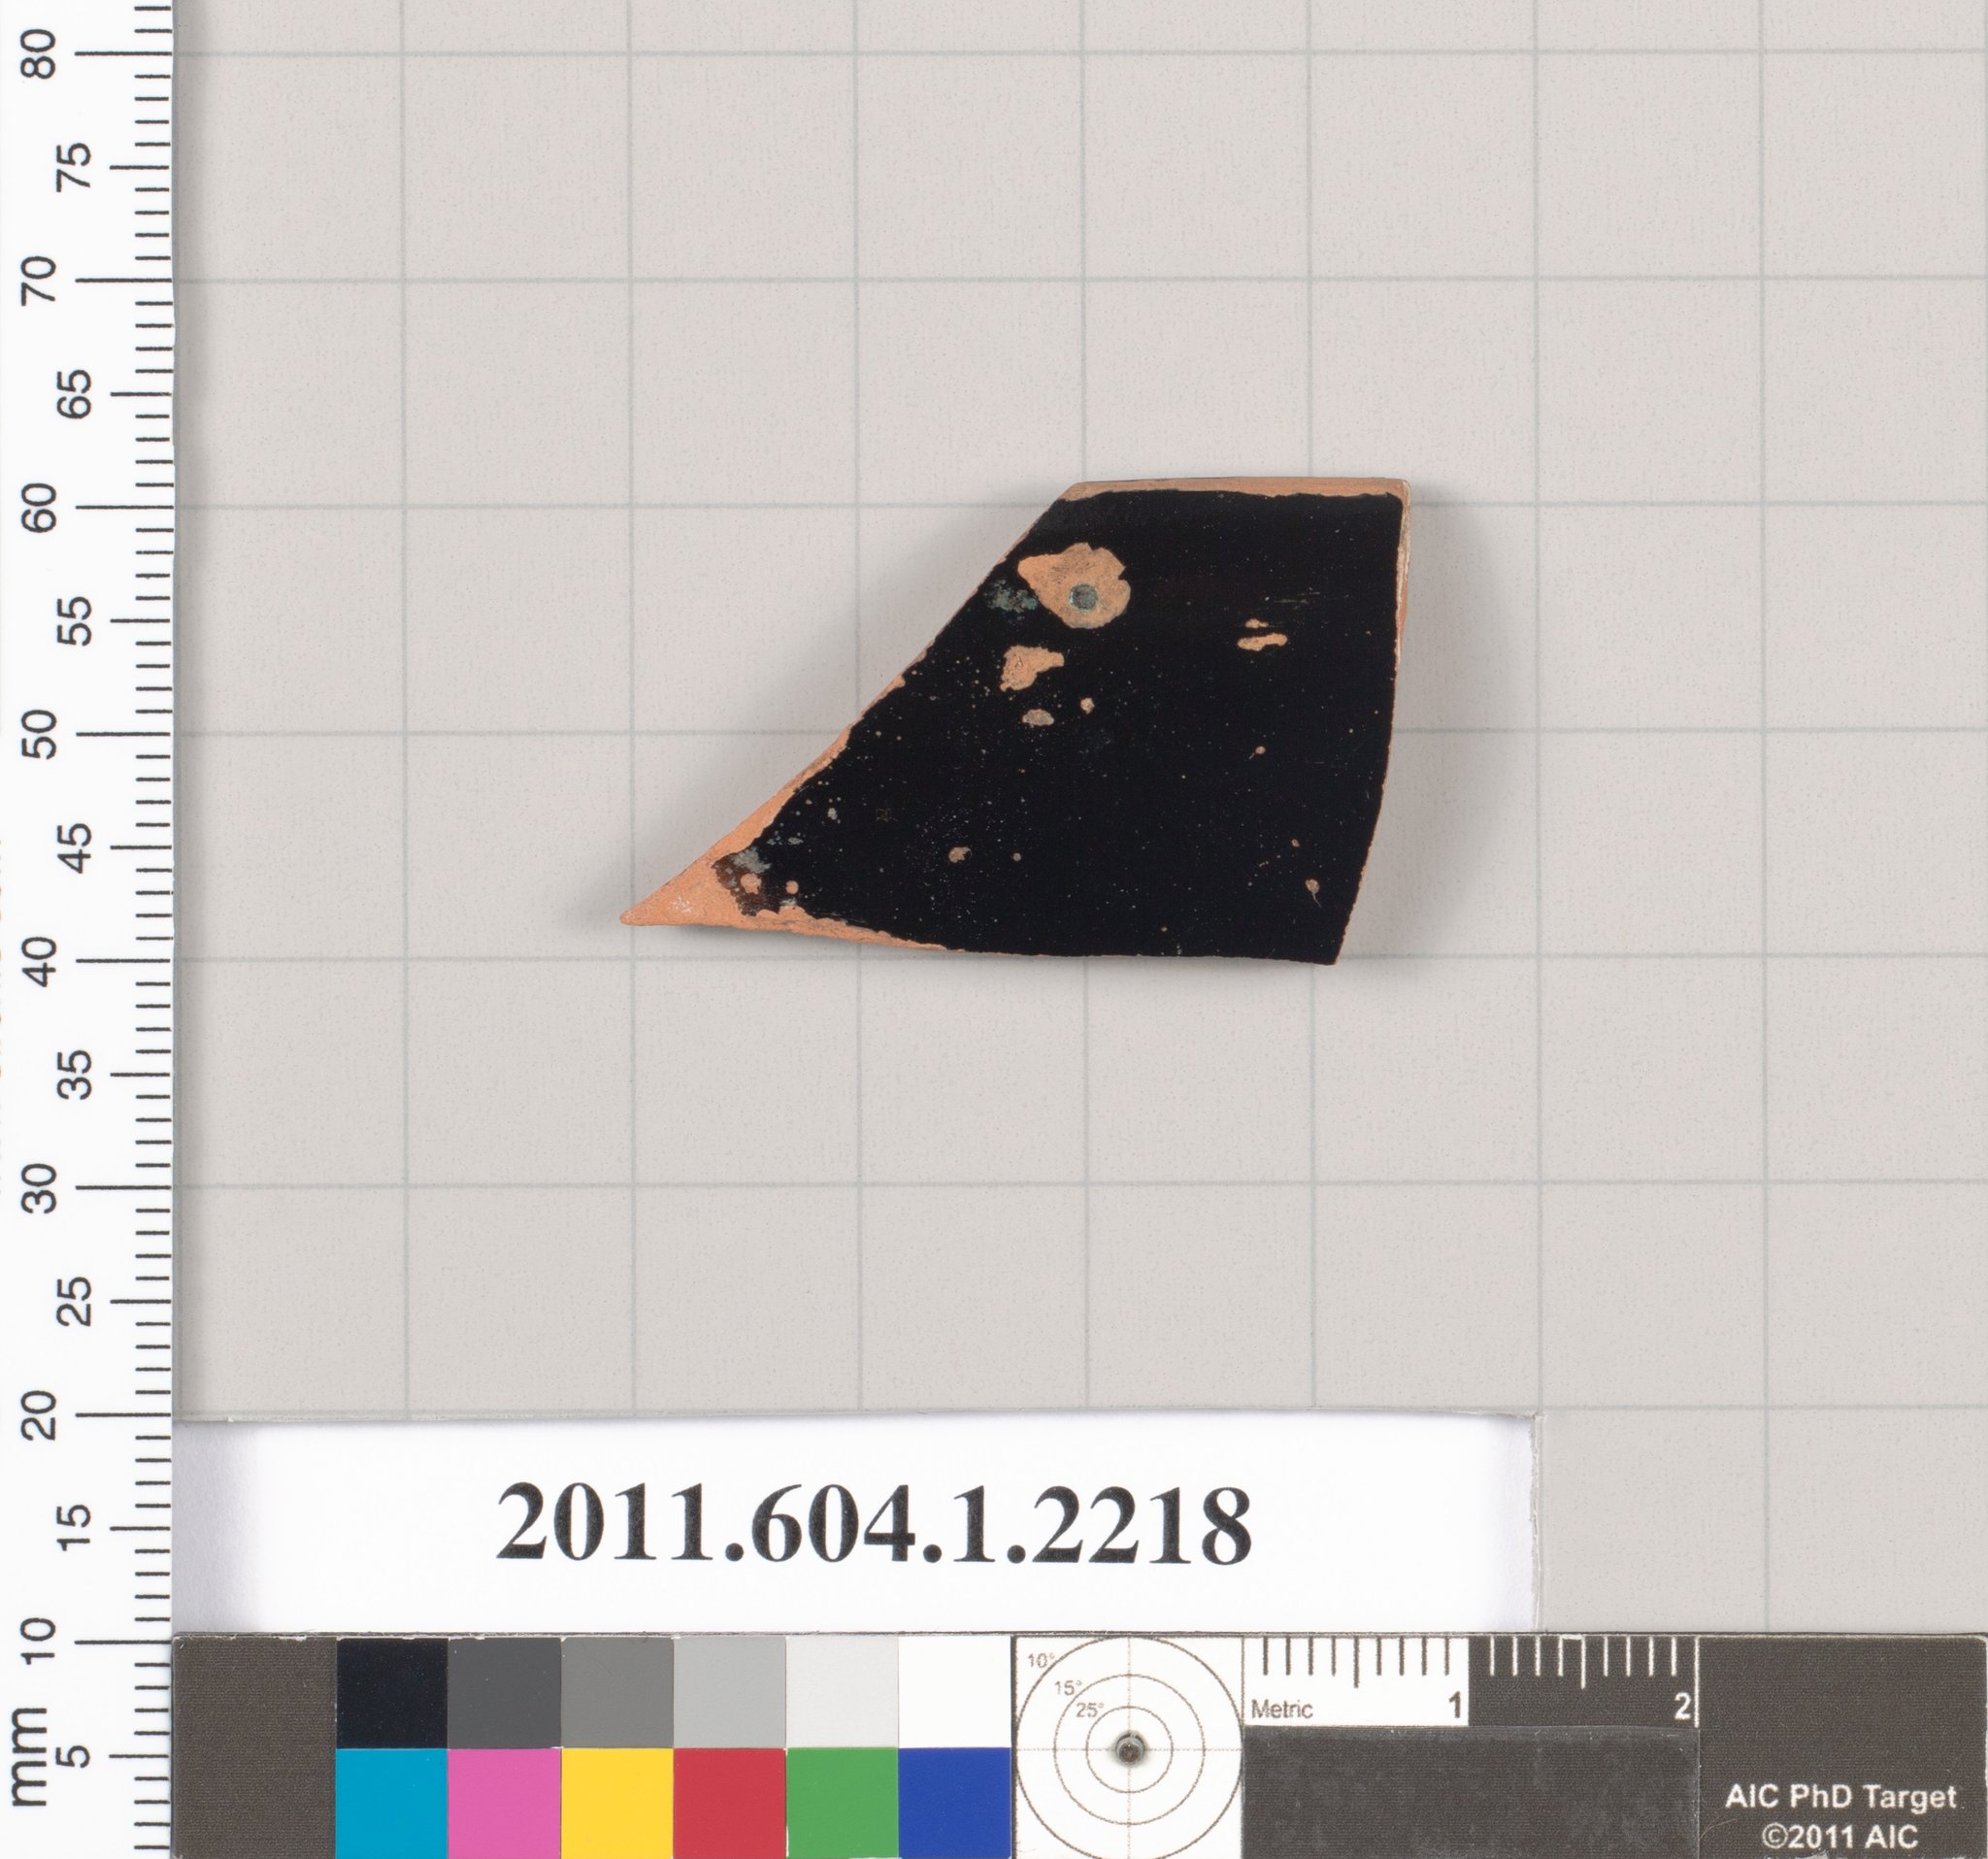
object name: kylix fragment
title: Terracotta rim fragment of a kylix (drinking cup)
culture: greek, attic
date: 500-401 BCE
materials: terracotta